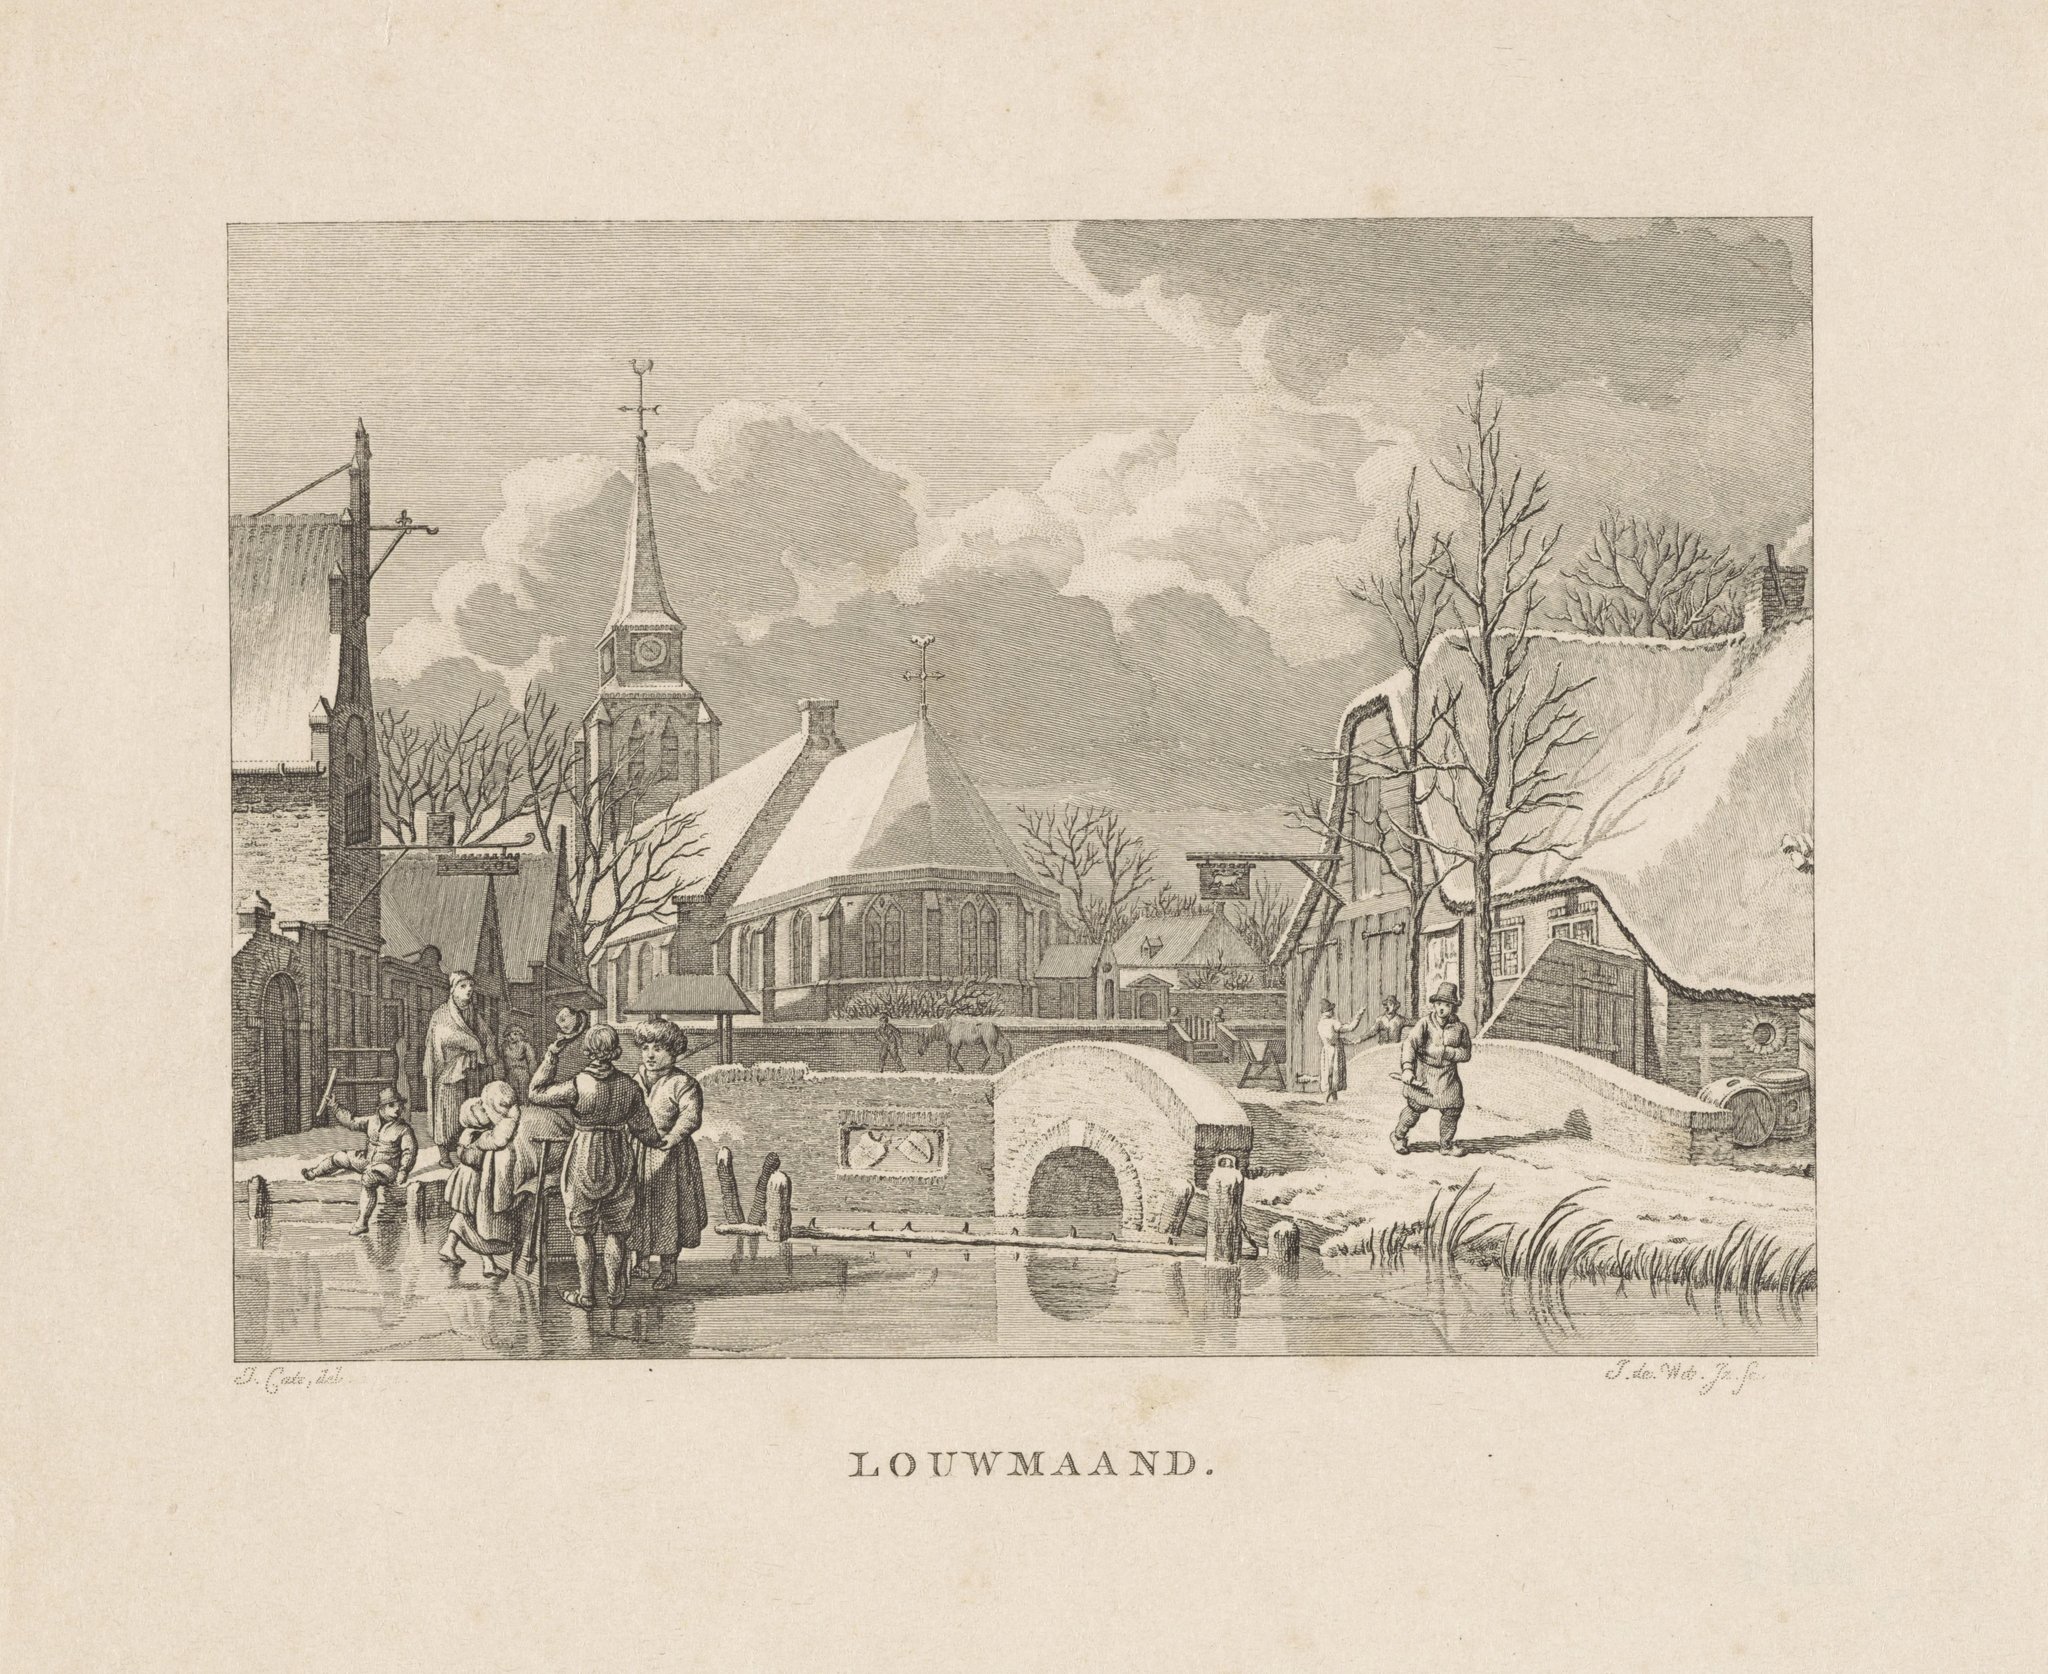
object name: print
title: De twaalf maanden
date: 1807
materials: paper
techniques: etching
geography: haarlem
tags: january and its 'labours' (+ with scenes showing human occupations ~ seasons and months), skates (winter sports)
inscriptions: signature: ‘J. cats del.’, title: ‘Louwmaand’, collector's mark: Lugt 2228, signature: ‘J. de Wit Jz. fc’